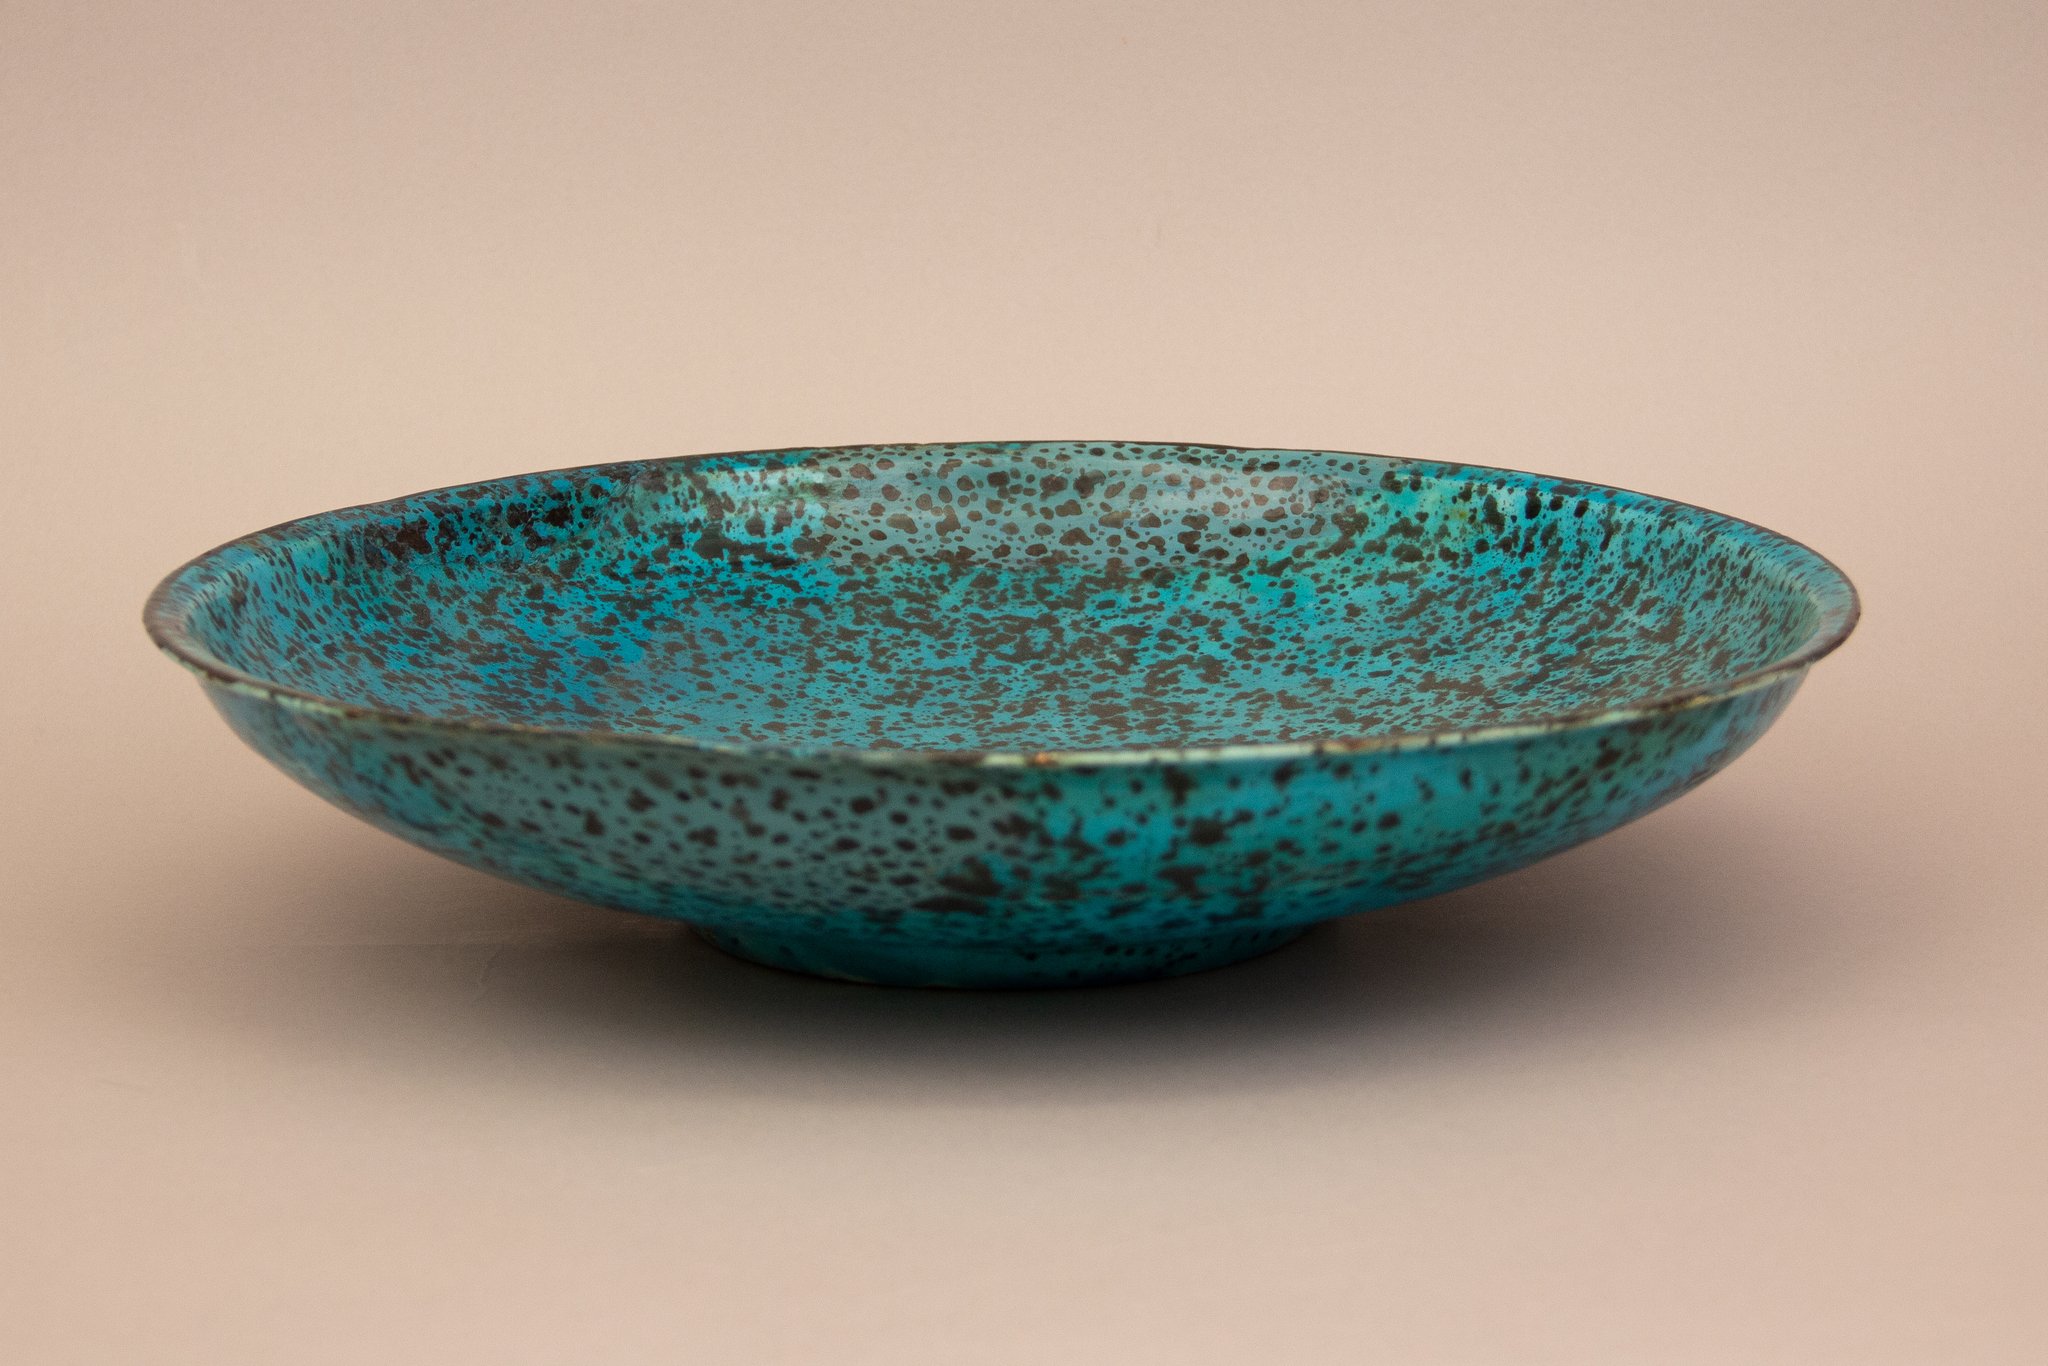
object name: dish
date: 1601-1800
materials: stonepaste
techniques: glazing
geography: iran